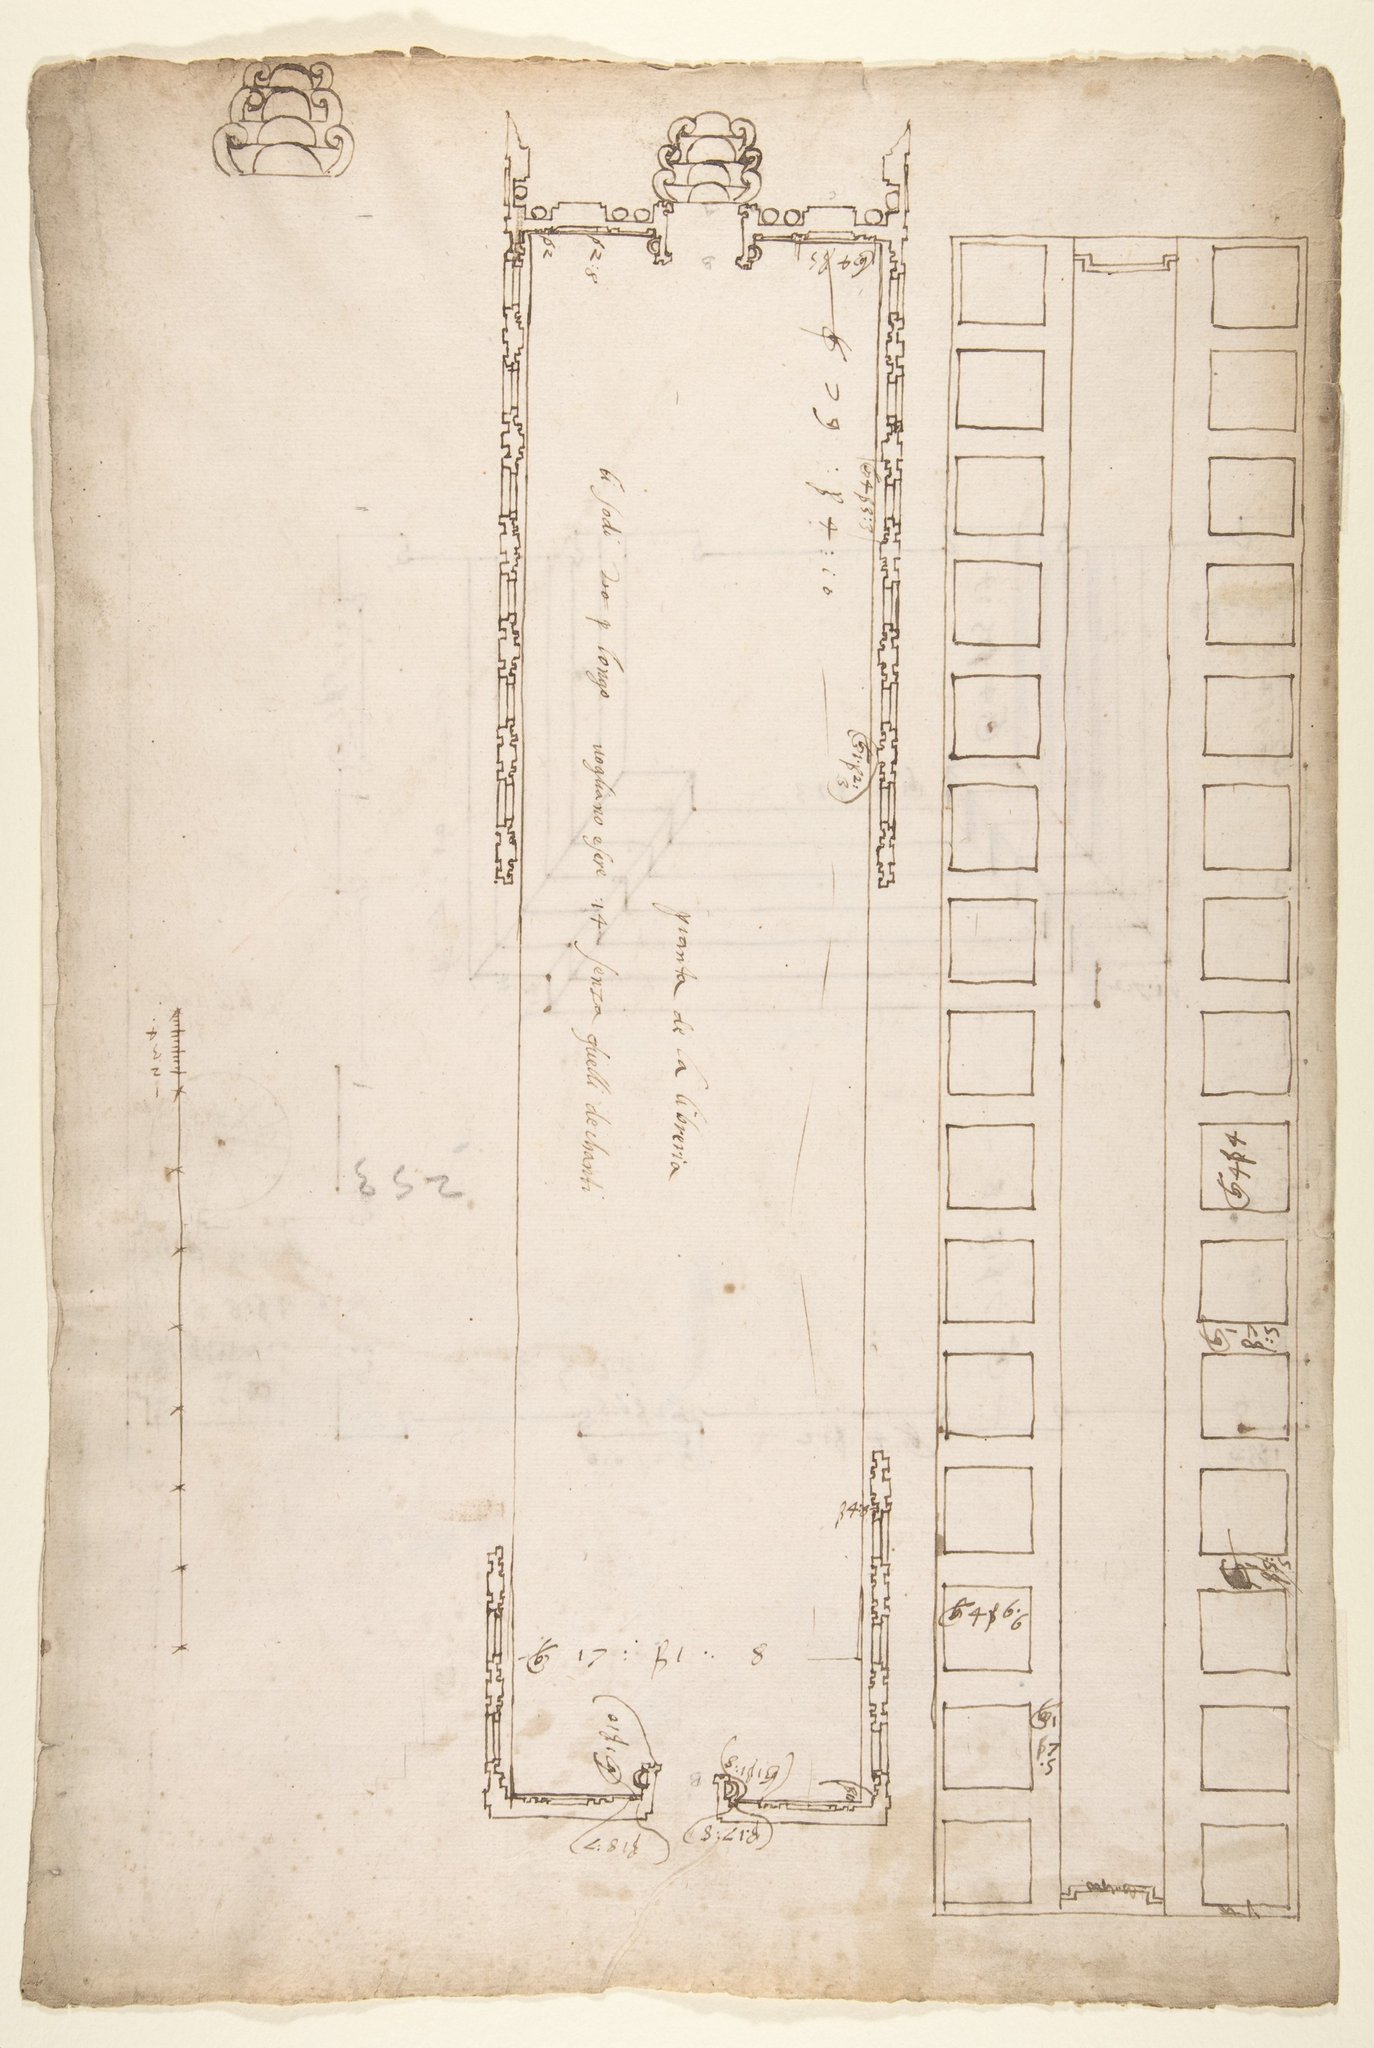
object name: drawing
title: San Lorenzo, Library, plan; reflected ceiling plan; stair, detail (recto) San Lorenzo, Ricetto, plan (verso)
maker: anonymous, french, 16th century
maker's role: draftsman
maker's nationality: french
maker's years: 1500-1600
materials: chalk, ink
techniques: incising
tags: architecture